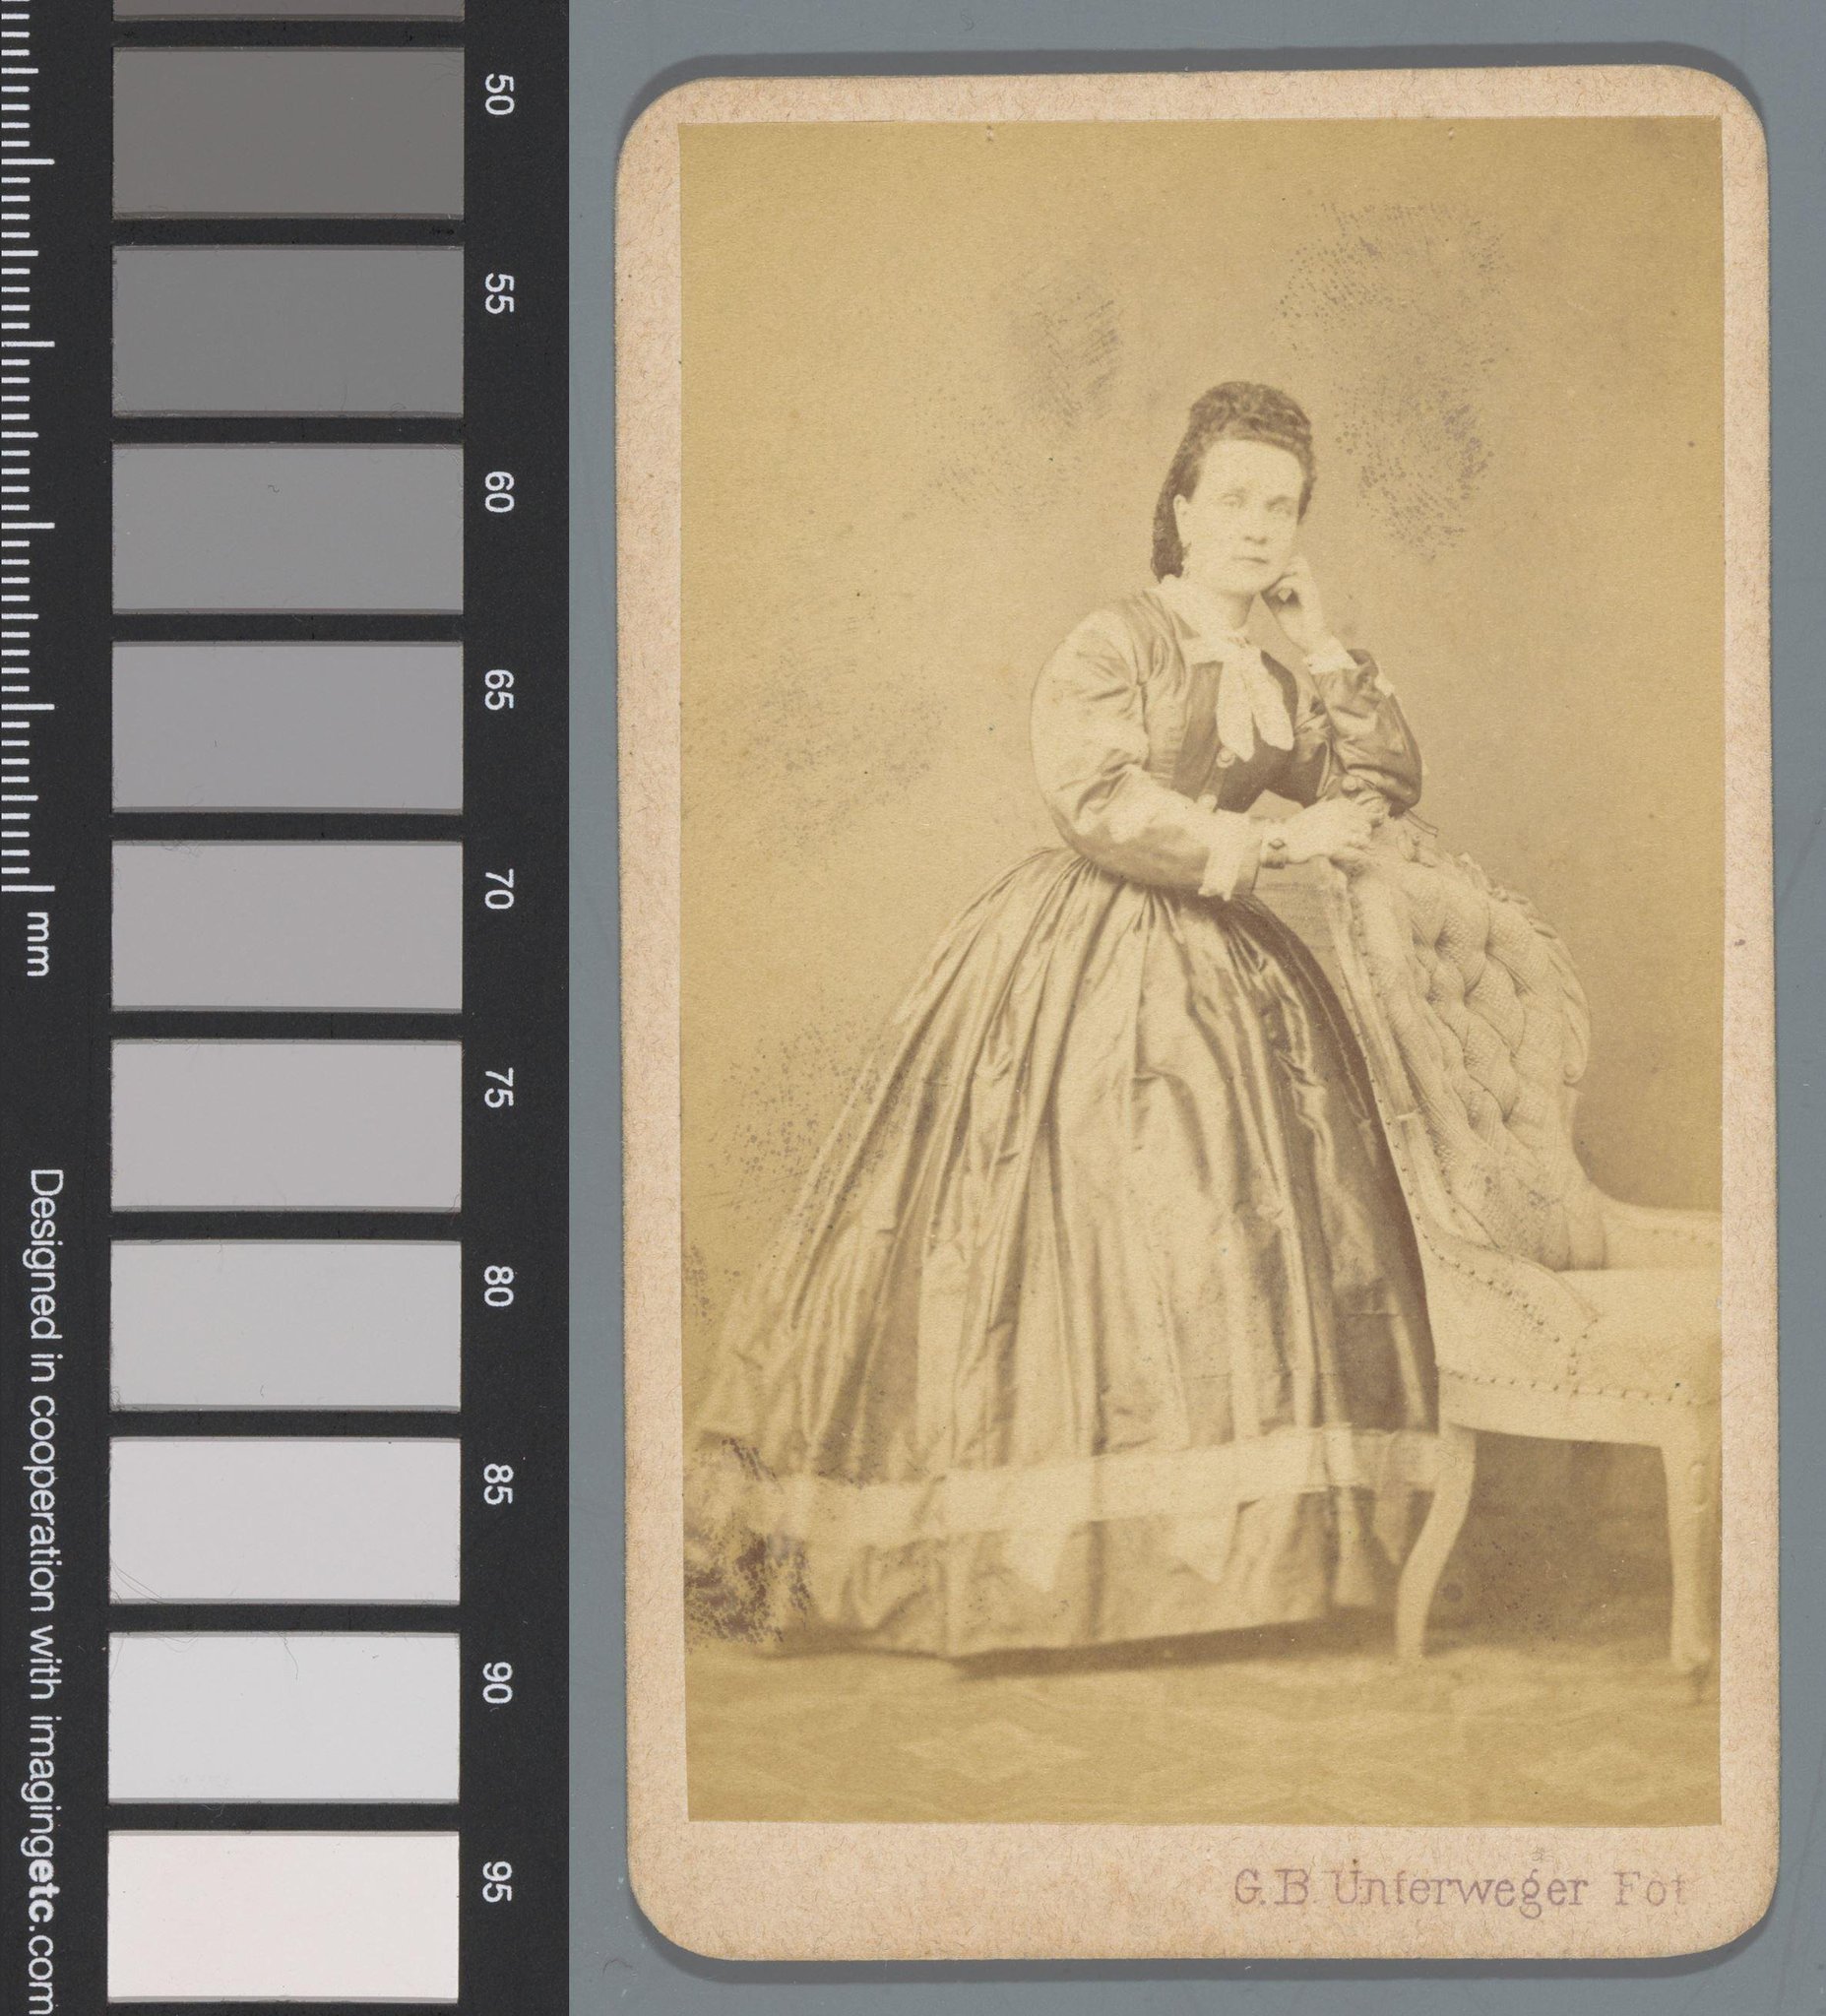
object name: carte de visite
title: Portret van een onbekende vrouw bij een stoel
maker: giovanni battista unterveger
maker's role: fotograaf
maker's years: 1833-1912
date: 1855-1885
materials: cardboard, paper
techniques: albumen print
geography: trento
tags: adult woman, anonymous historical person portrayed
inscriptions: inscription: ‘G.B. Unterweger/ fotografo/ Piazzetta delle Opere/ No. 334/ Trento’, inscription: ‘G.B. Unterweger Fot.’